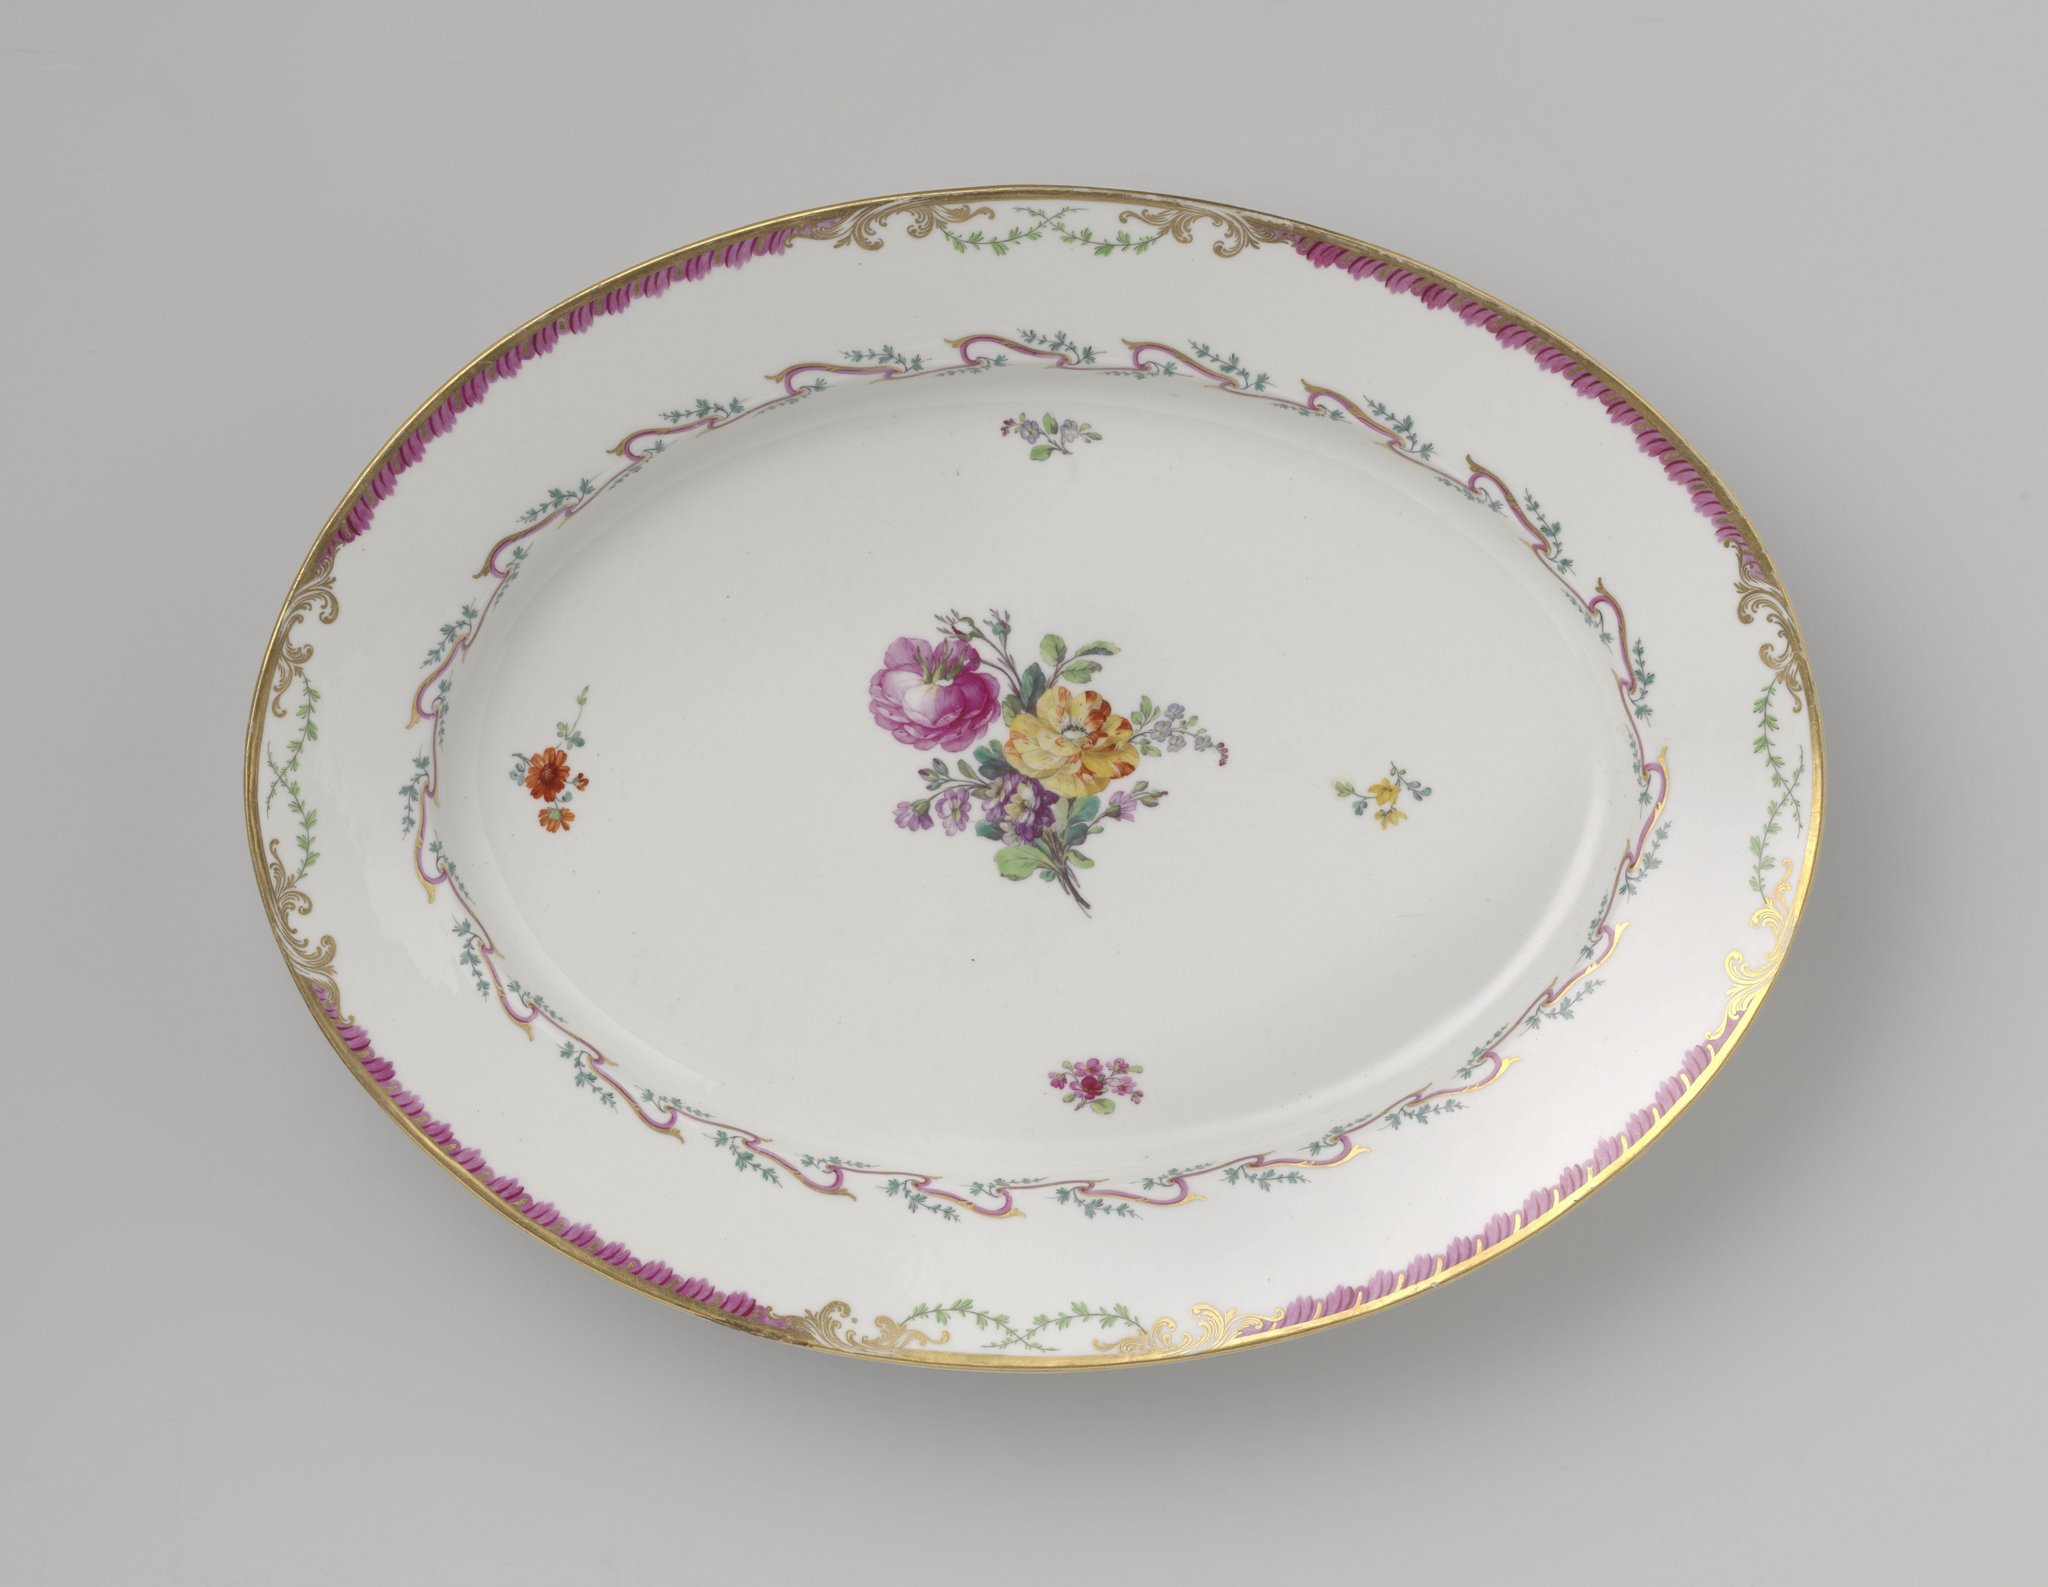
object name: platter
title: Oval dish with a bouquet, flower sprays and foliate scrolls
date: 1780-1820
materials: glaze, gold, paint, porcelain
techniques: firing, gilding, turning, vitrification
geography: berlin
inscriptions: mark: ‘scepter/ 26/ IIII’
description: Ovale schaal van porselein, beschilderd op het glazuur in blauw, rood, roze, groen, geel, paars, zwart en goud. Op het plat een boeket van verschillende bloemen en vier kleine bloemtakken. Op de wand een doorlopende bladrank. De rand met een decoratieve band met krulwerk en gekruiste takken. Een extra S-vormige voet in het centrum van de onderzijde. Gemerkt op de onderzijde met de scepter, het nummer 26 en IIII.